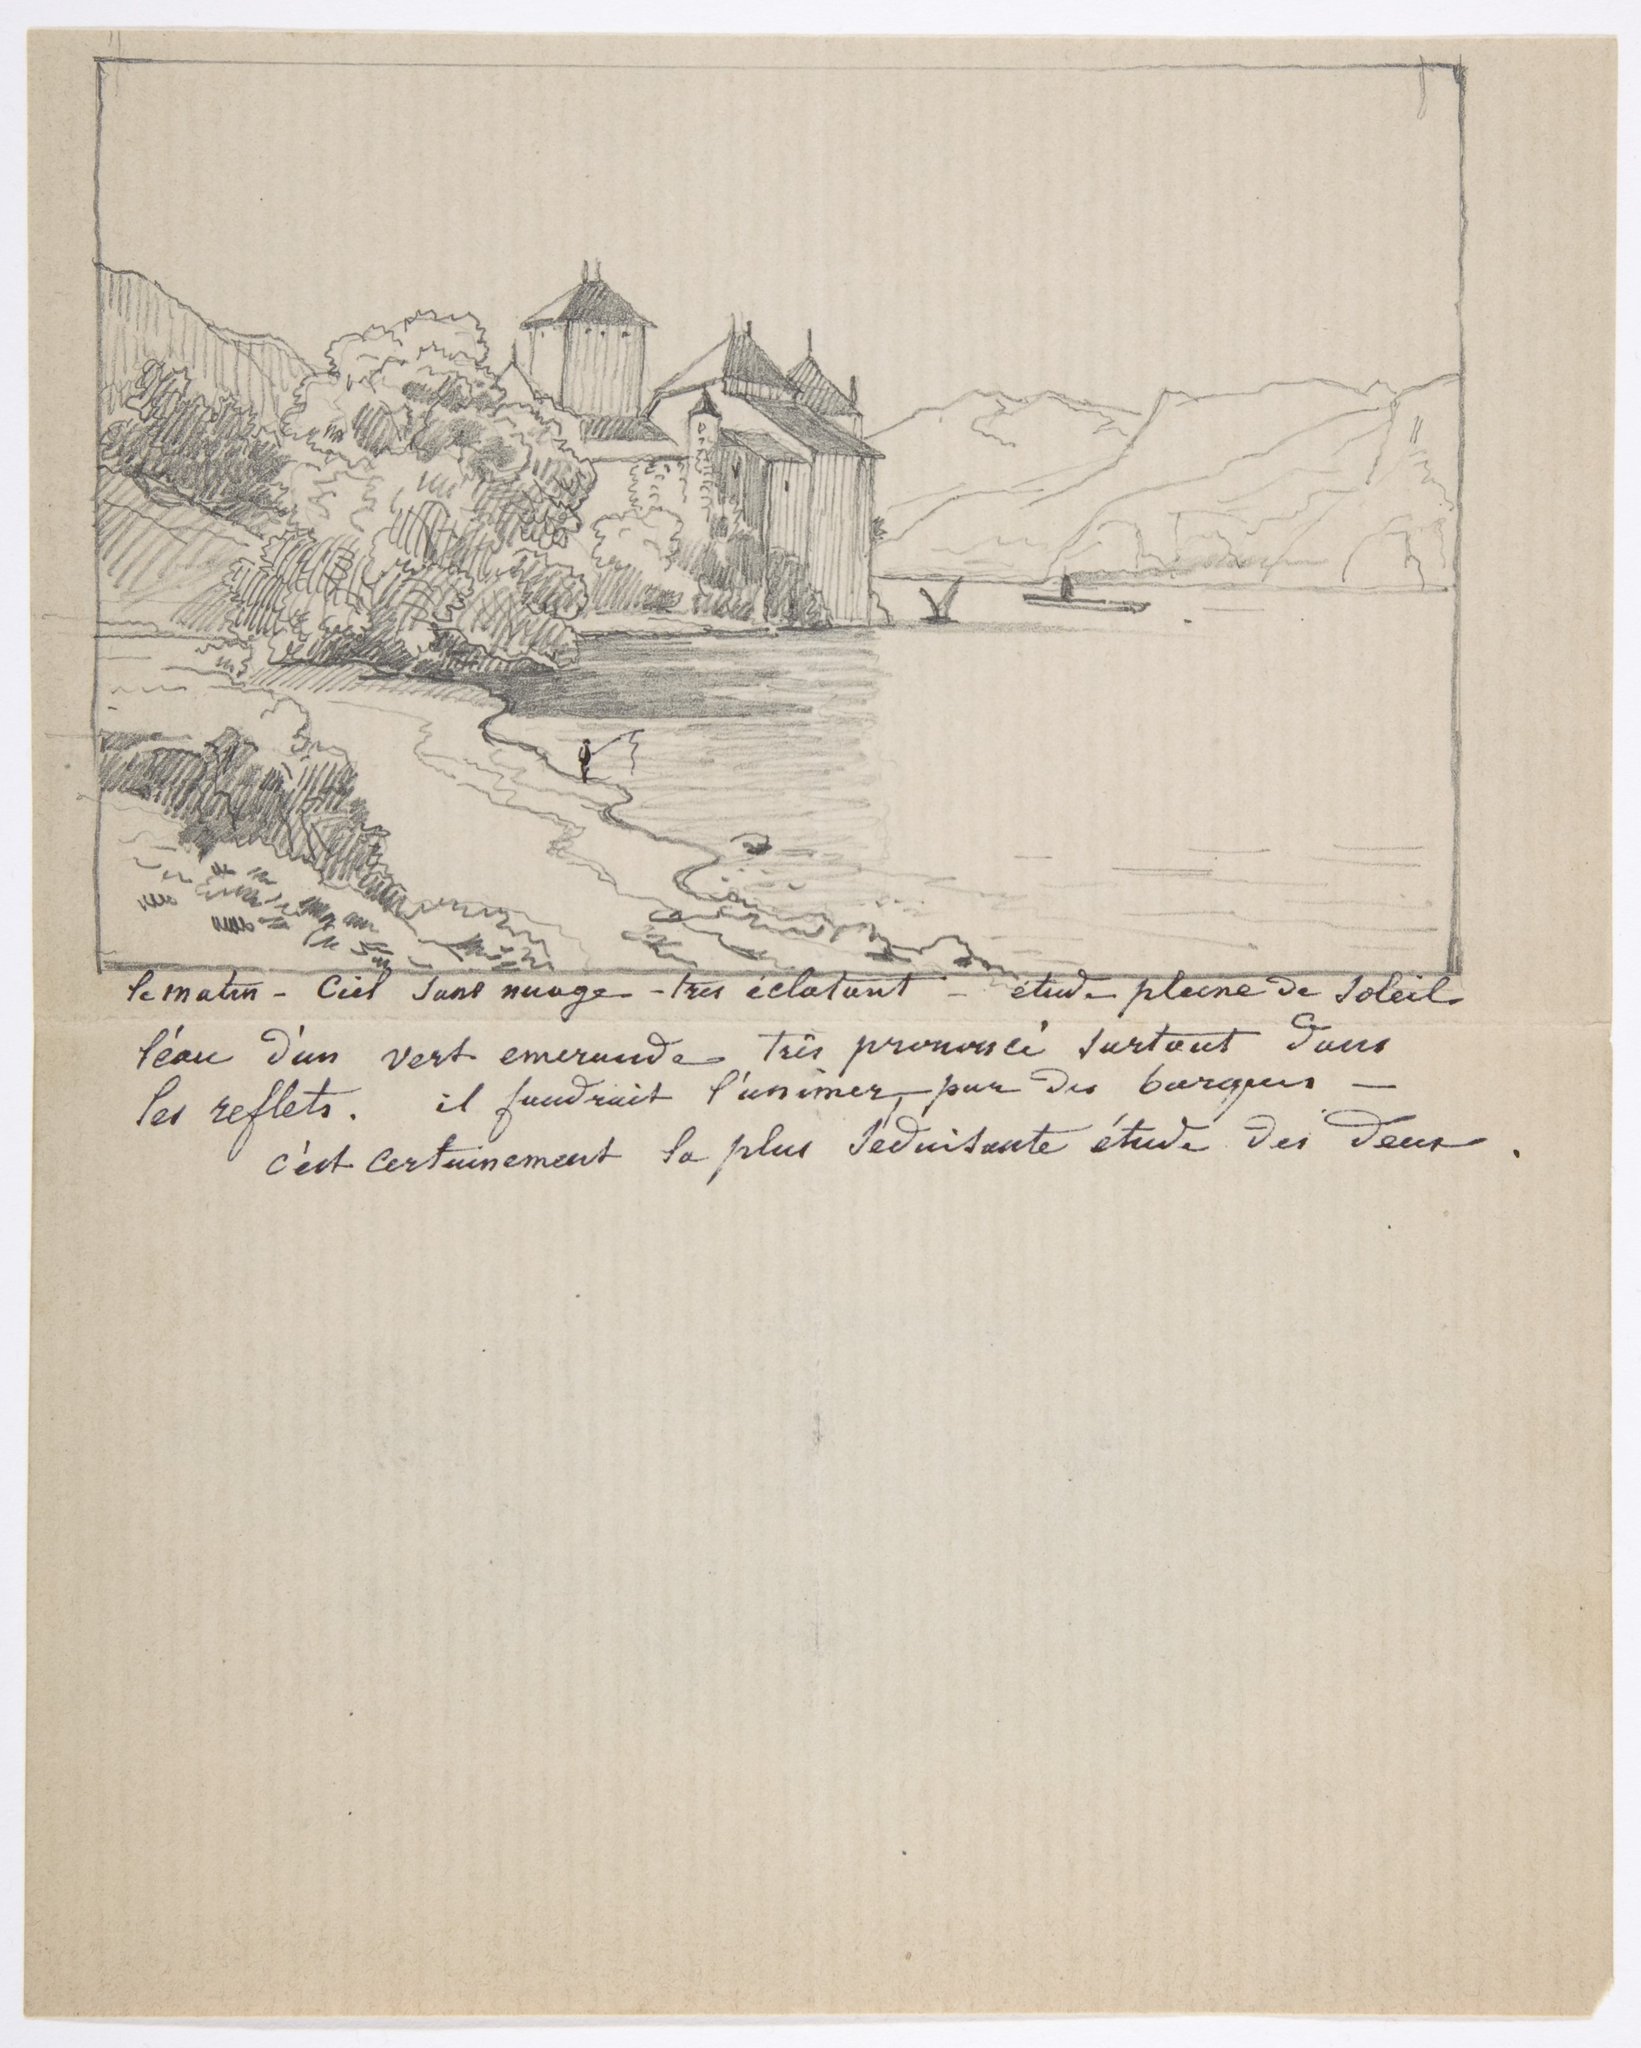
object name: drawing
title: View of the Château de Chillon on Lake Geneva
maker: anonymous, french, 19th century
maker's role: artist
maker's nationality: french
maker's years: 1800-1900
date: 1801-1900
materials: graphite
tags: buildings,fishing,lakes,hills,boats